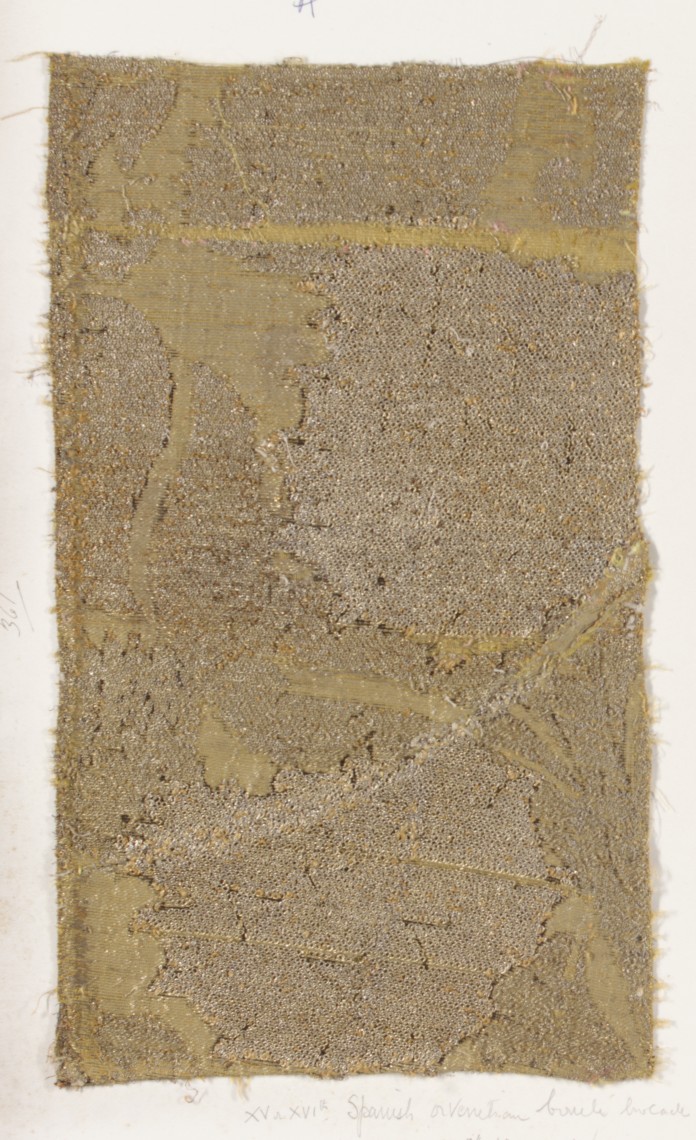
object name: fragment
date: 1401-1600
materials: metal thread, silk